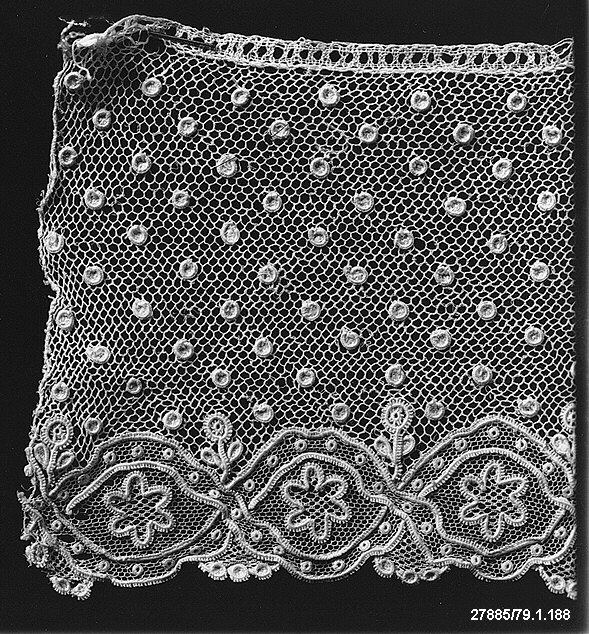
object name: strip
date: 1801-1900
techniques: lace